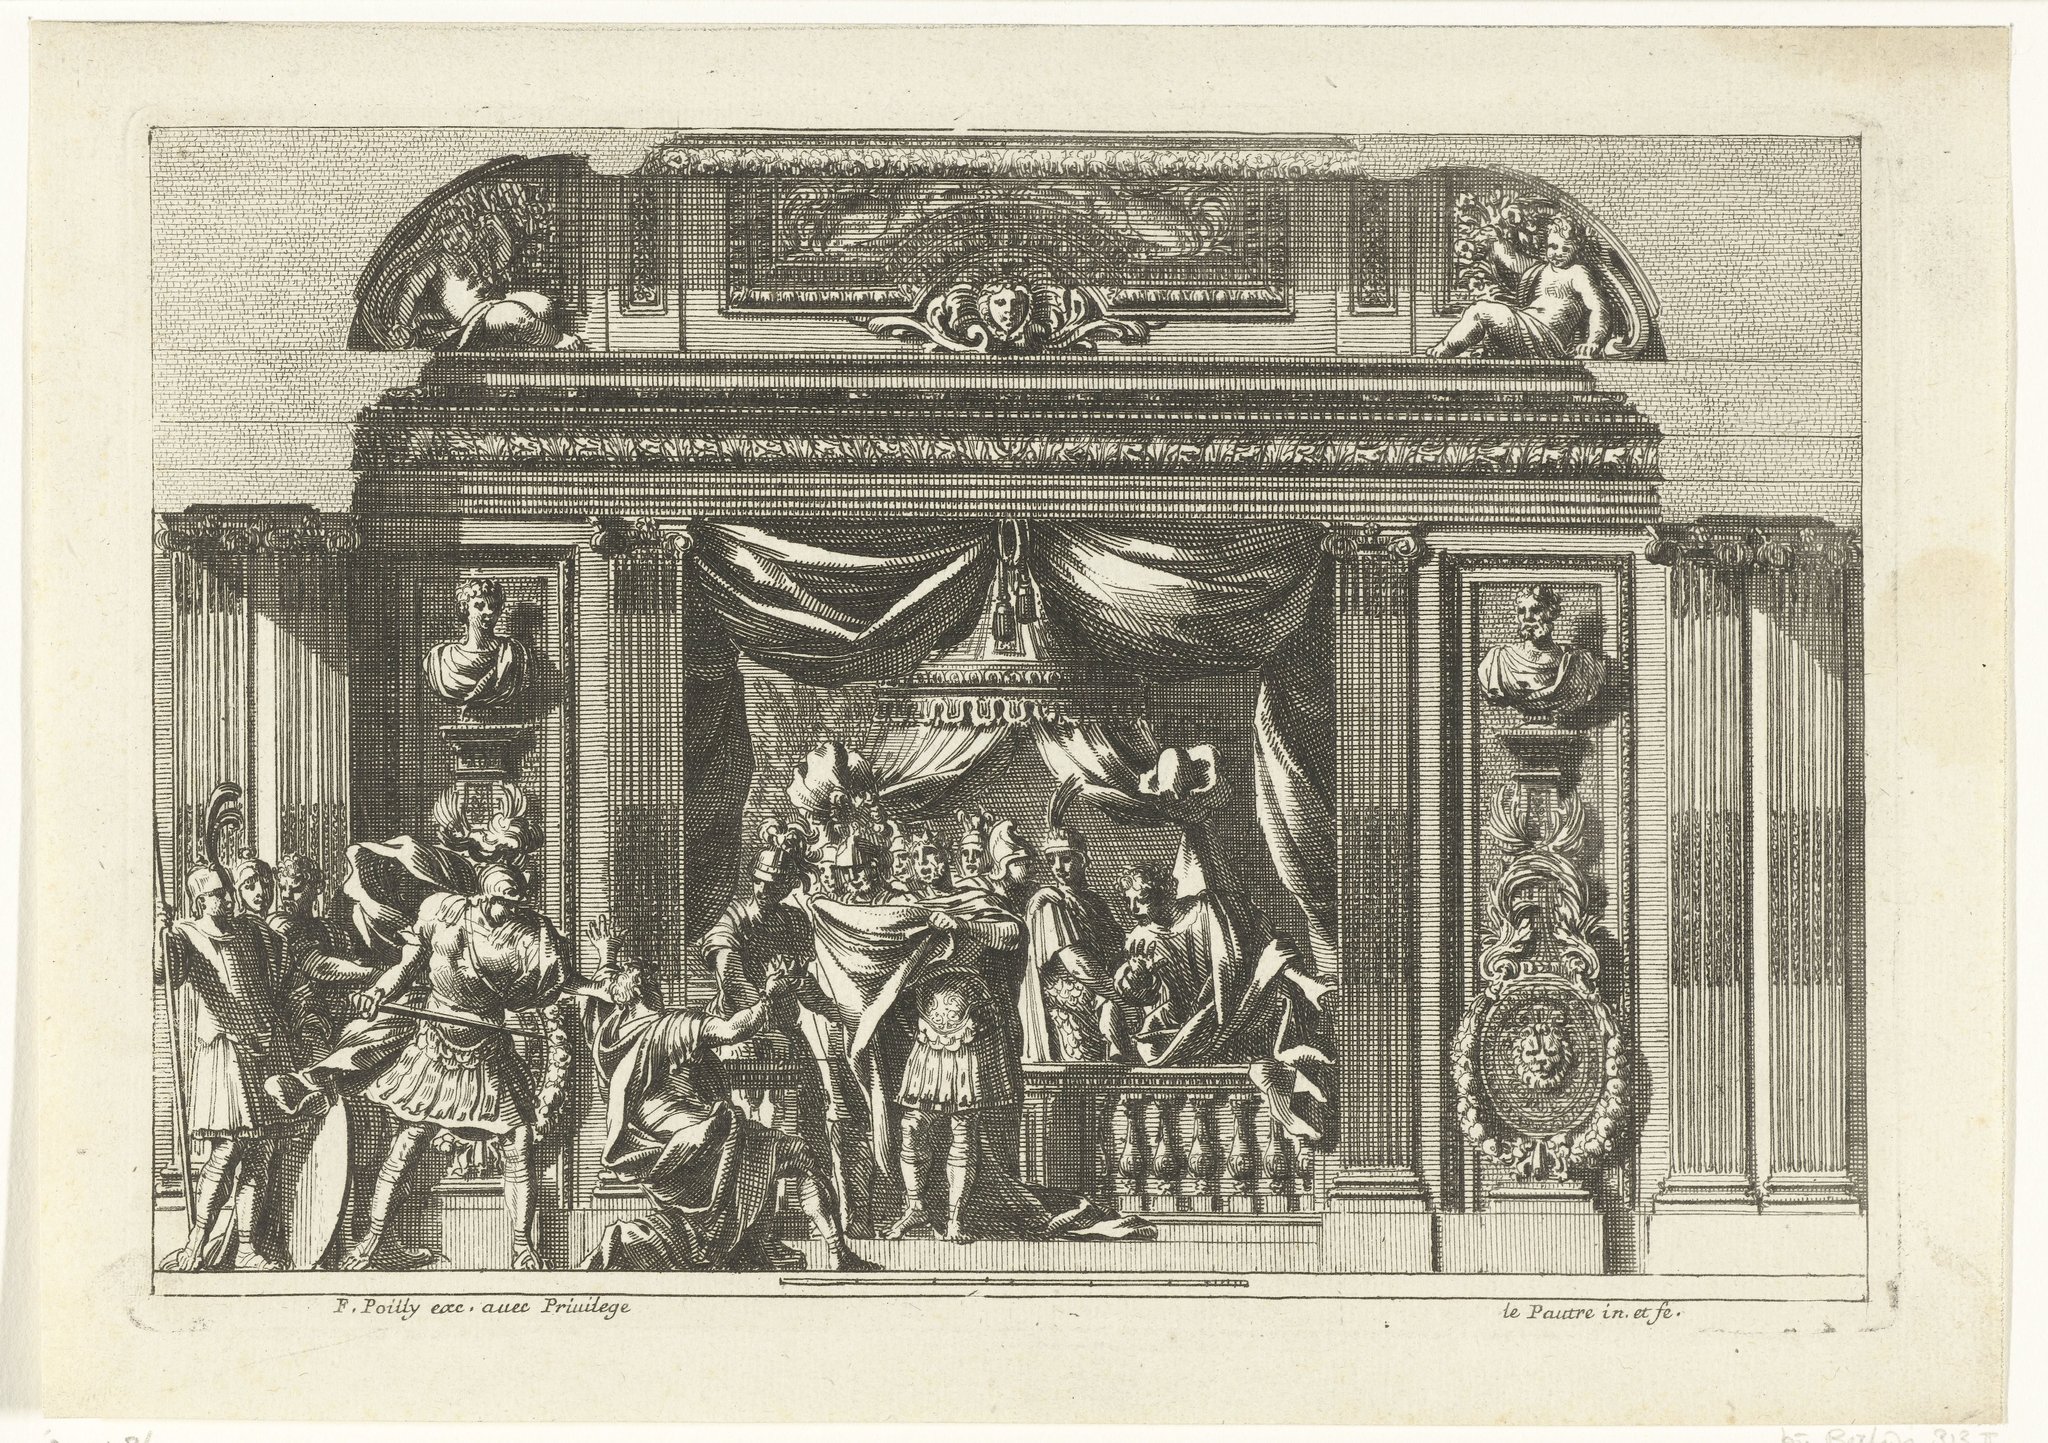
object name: print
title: Alkoof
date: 1665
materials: paper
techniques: etching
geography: paris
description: Op de voorgrond staat een soldaat op het punt een man neer te steken die voor een koning knielt.